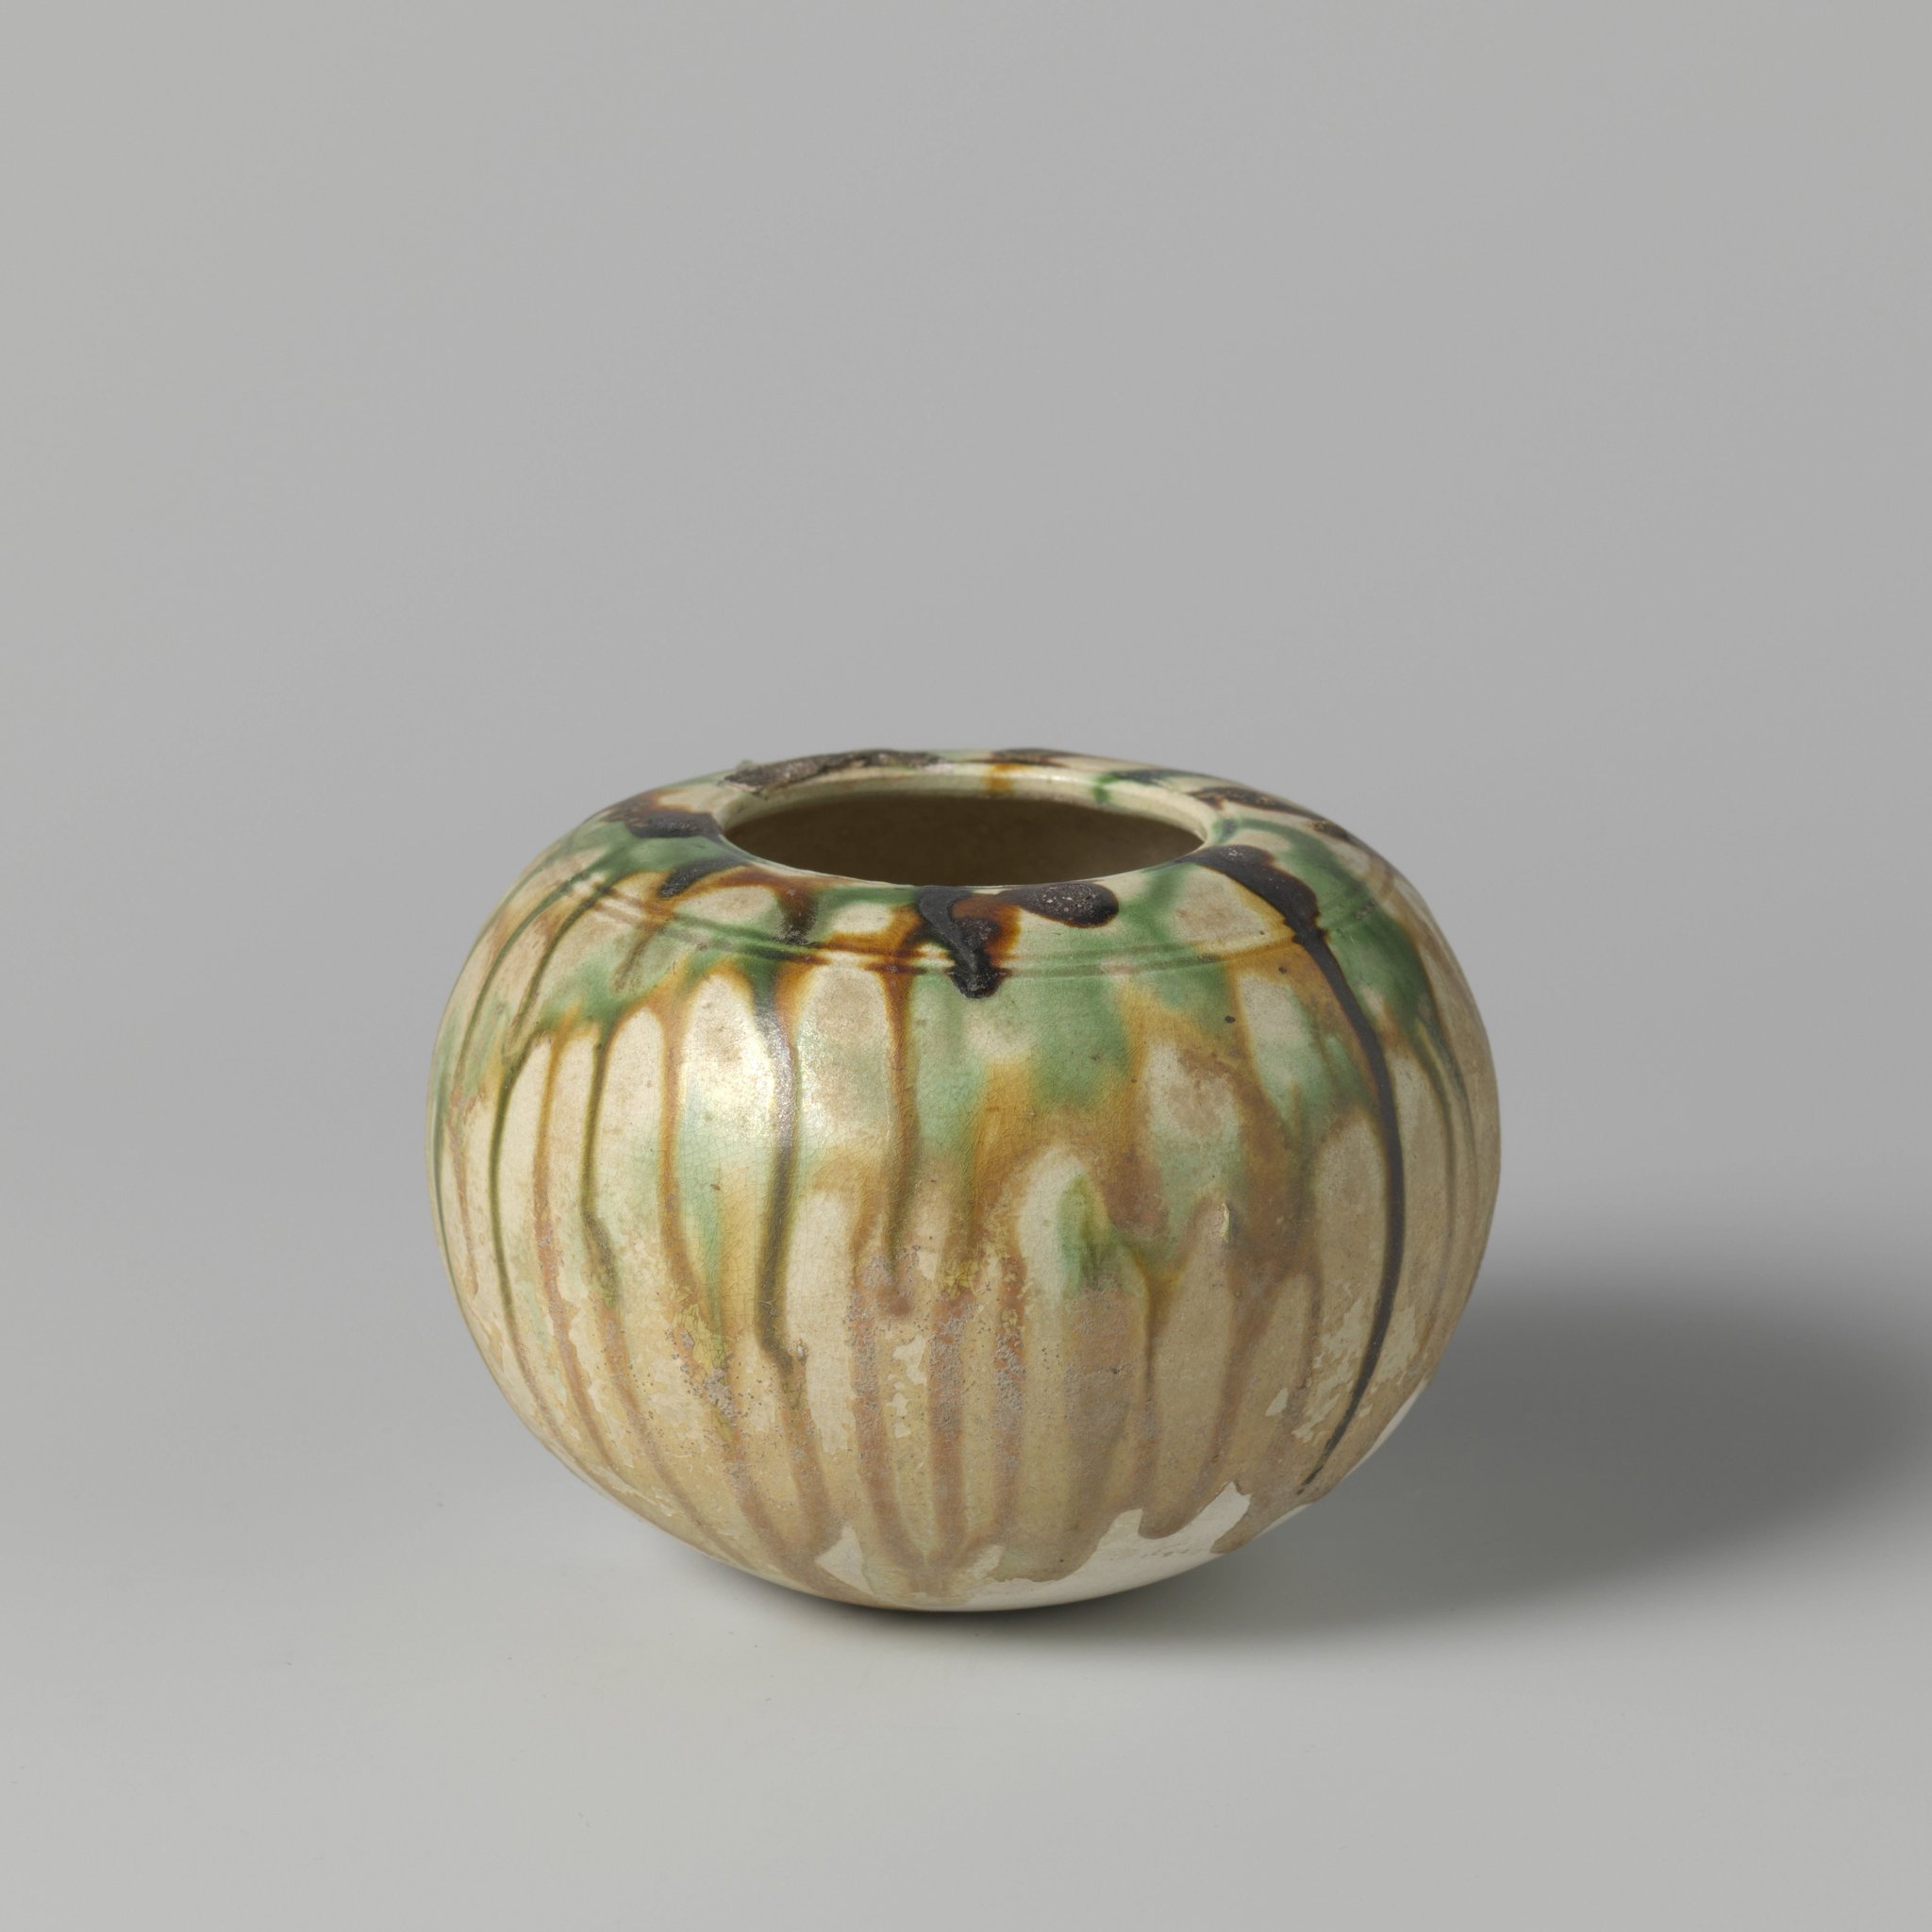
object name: covered jar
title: Covered jar with a three-colored glaze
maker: Anonymous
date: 618-906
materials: earthenware, glaze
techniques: firing, turning, vitrification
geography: china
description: Dekselpot van aardewerk met een bolvormig lichaam, bedekt met een groen, bruin en crèmekleurig glazuur. De deksel met bruine en groene vlekken. Sancai, Tang.